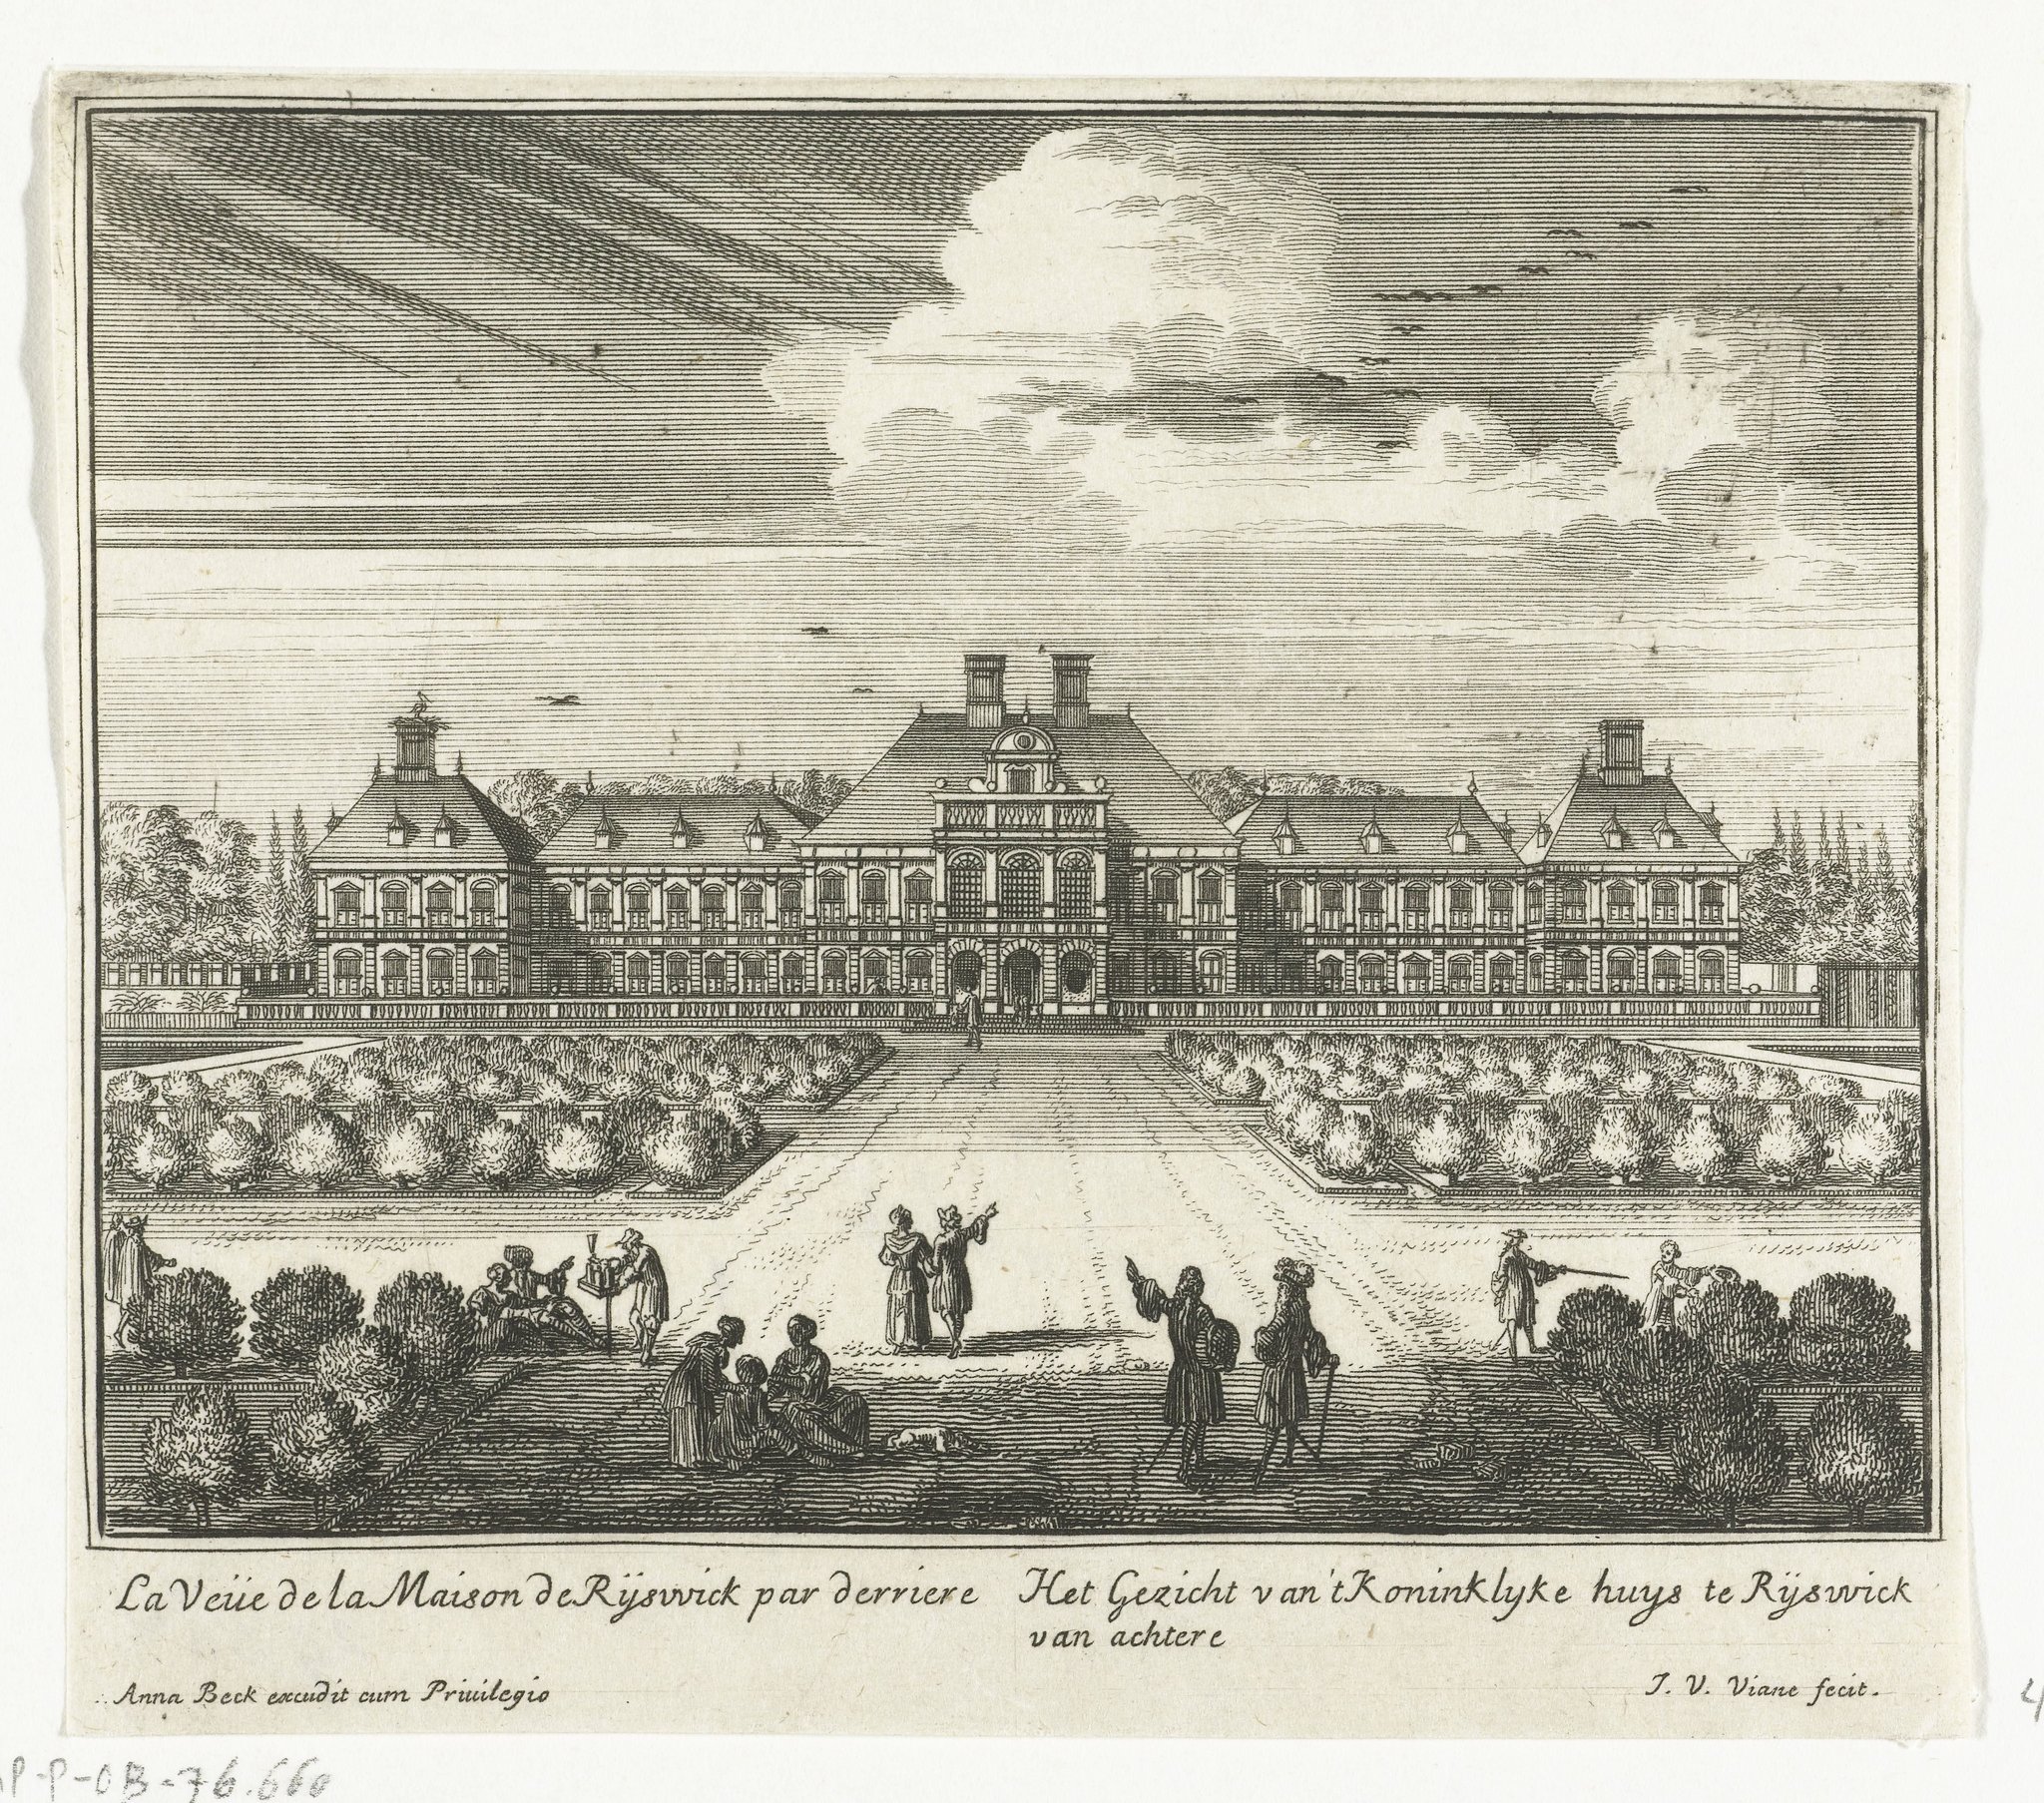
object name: print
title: Het Gezicht van 't Koninklyke huys te Ryswick van achtere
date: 1697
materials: paper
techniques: etching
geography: the hague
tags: palace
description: Gezicht op het Huis ter Nieuburch in Rijswijk, achterzijde. In het onderschrift de twee titels in het Frans en Nederlands. Onderdeel (prent 4) van de serie van zestien kleinere prenten over het Huis ter Nieuburch in Rijswijk en de daar gehouden vredesonderhandelingen resulterend in de Vrede van Rijswijk gesloten op 20 september 1697.